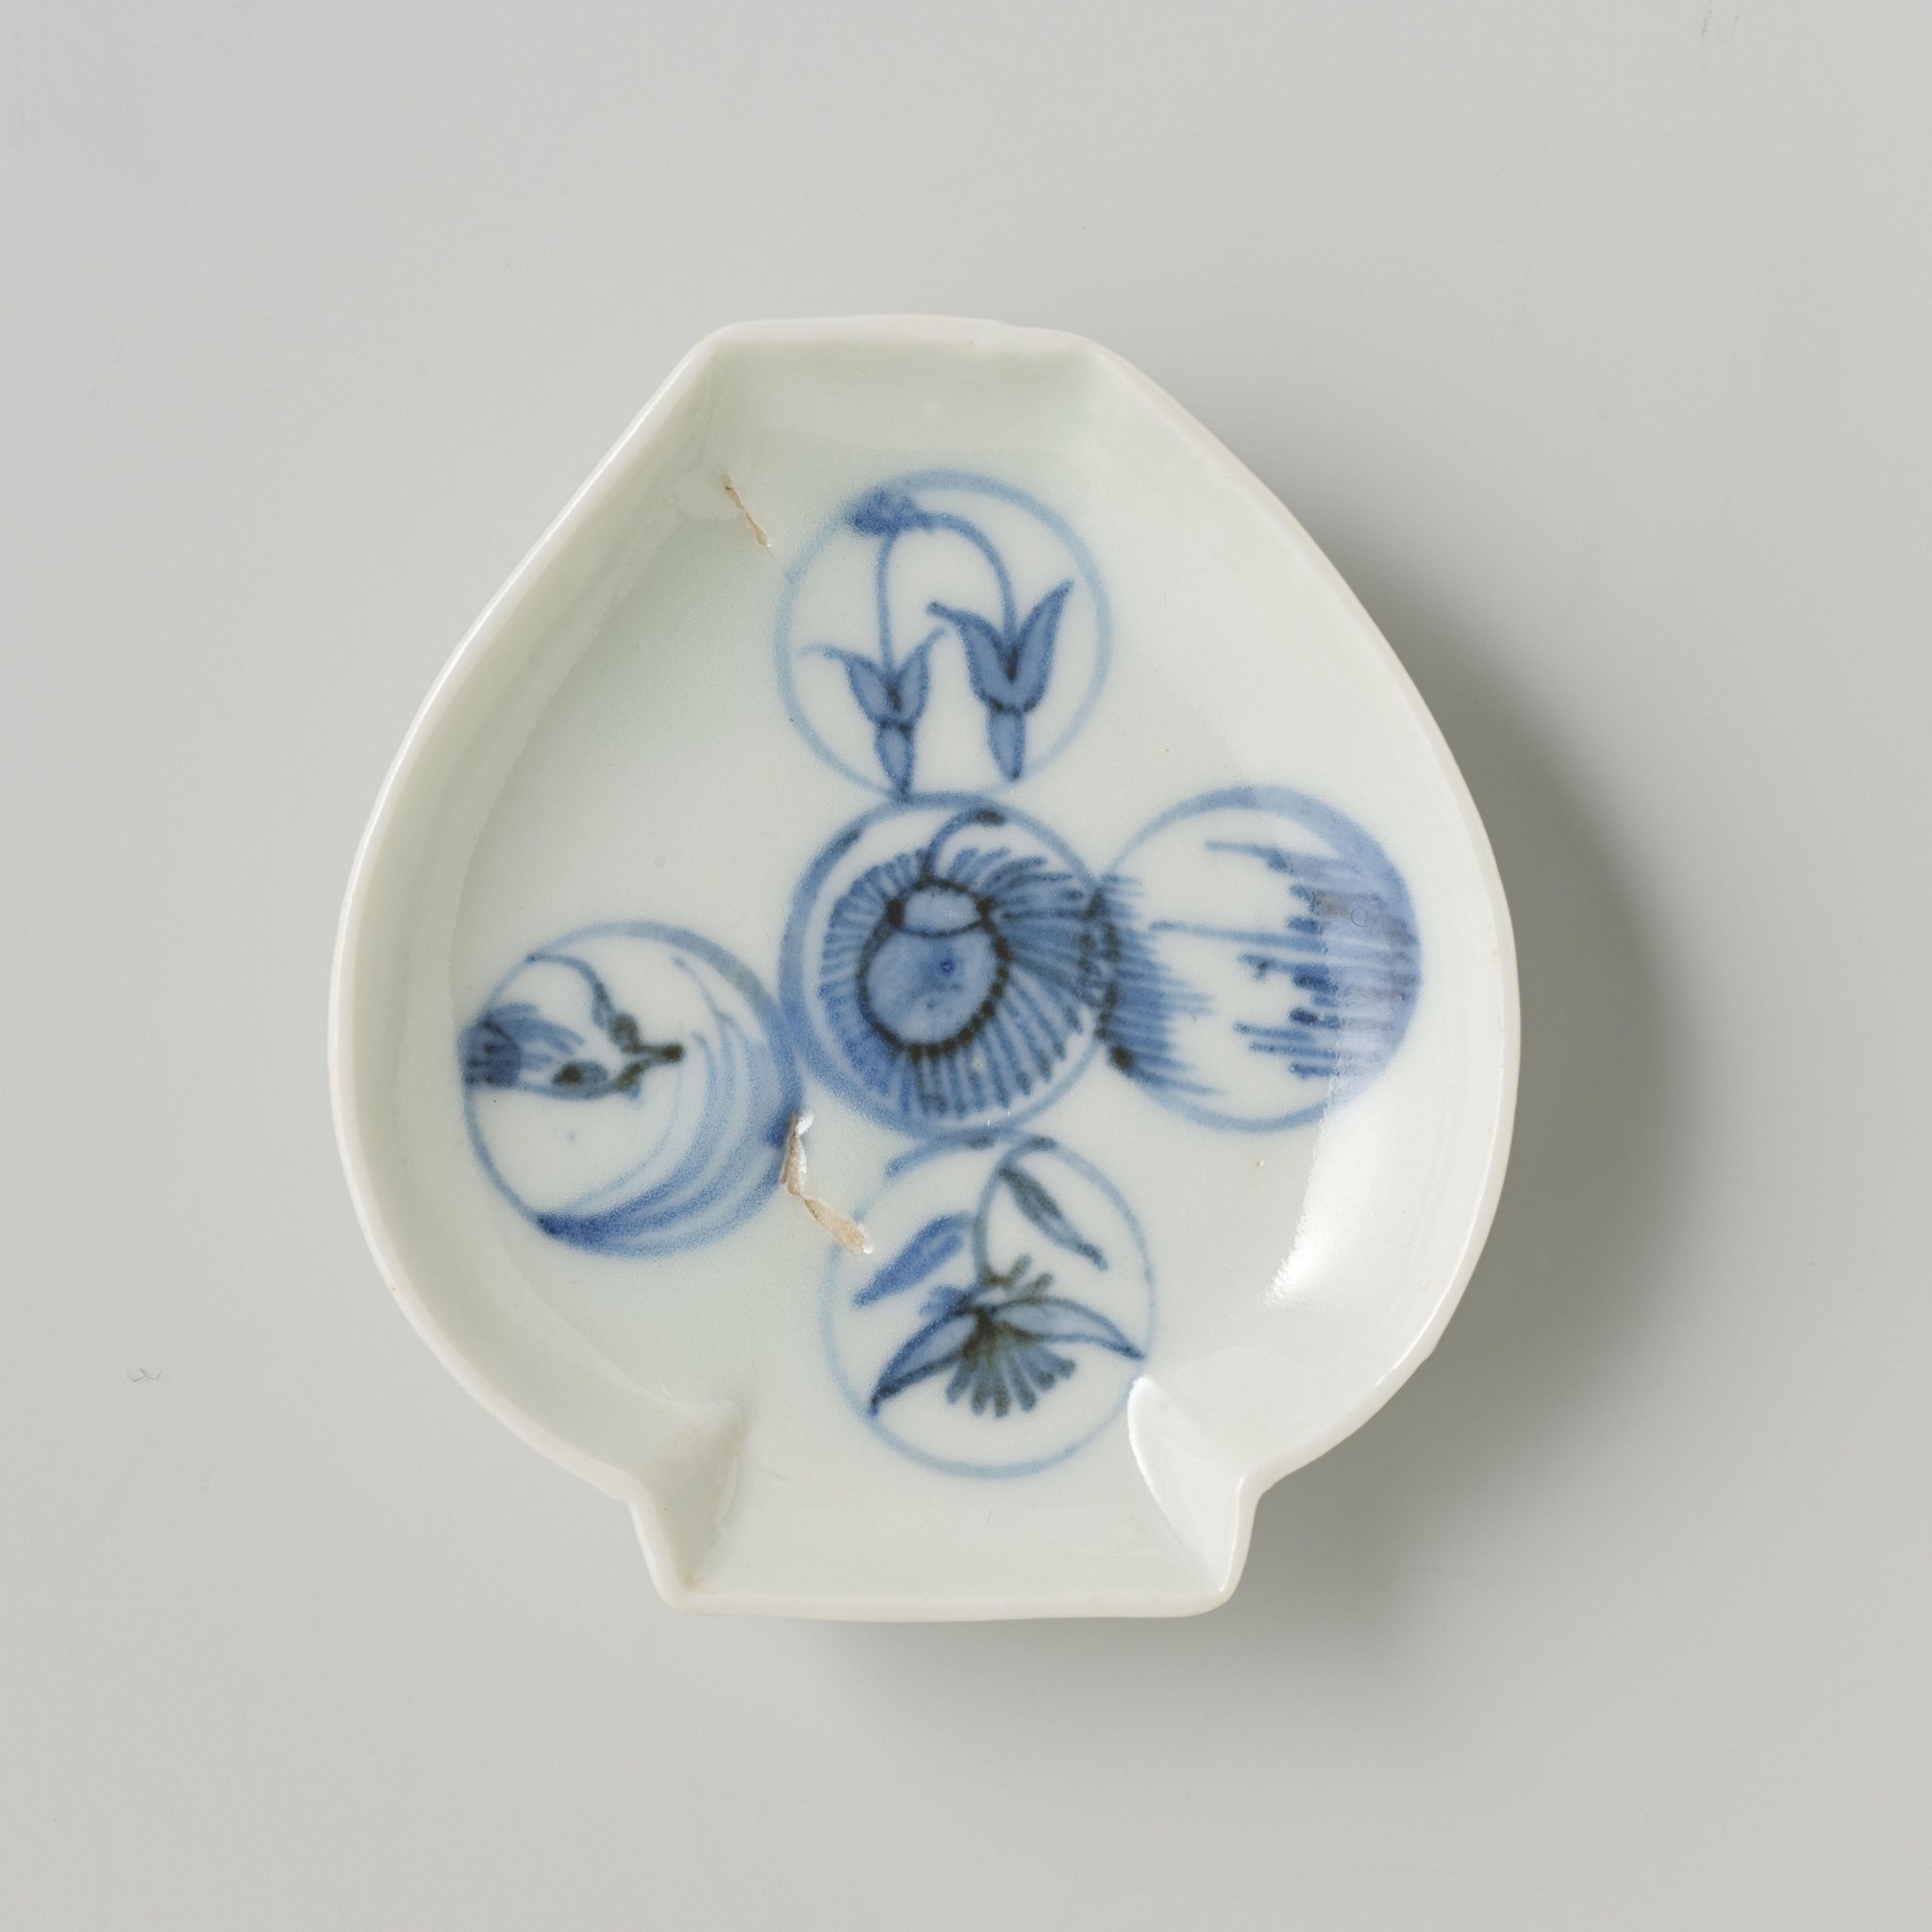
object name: dish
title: Schotel van porselein in de vorm van een gesloten lotusbloem (?). Blauwe onderglazuur decoratie van vijf cirkels met Japanse man (bloemen).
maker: Anonymous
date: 1680-1710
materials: porcelain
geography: japan